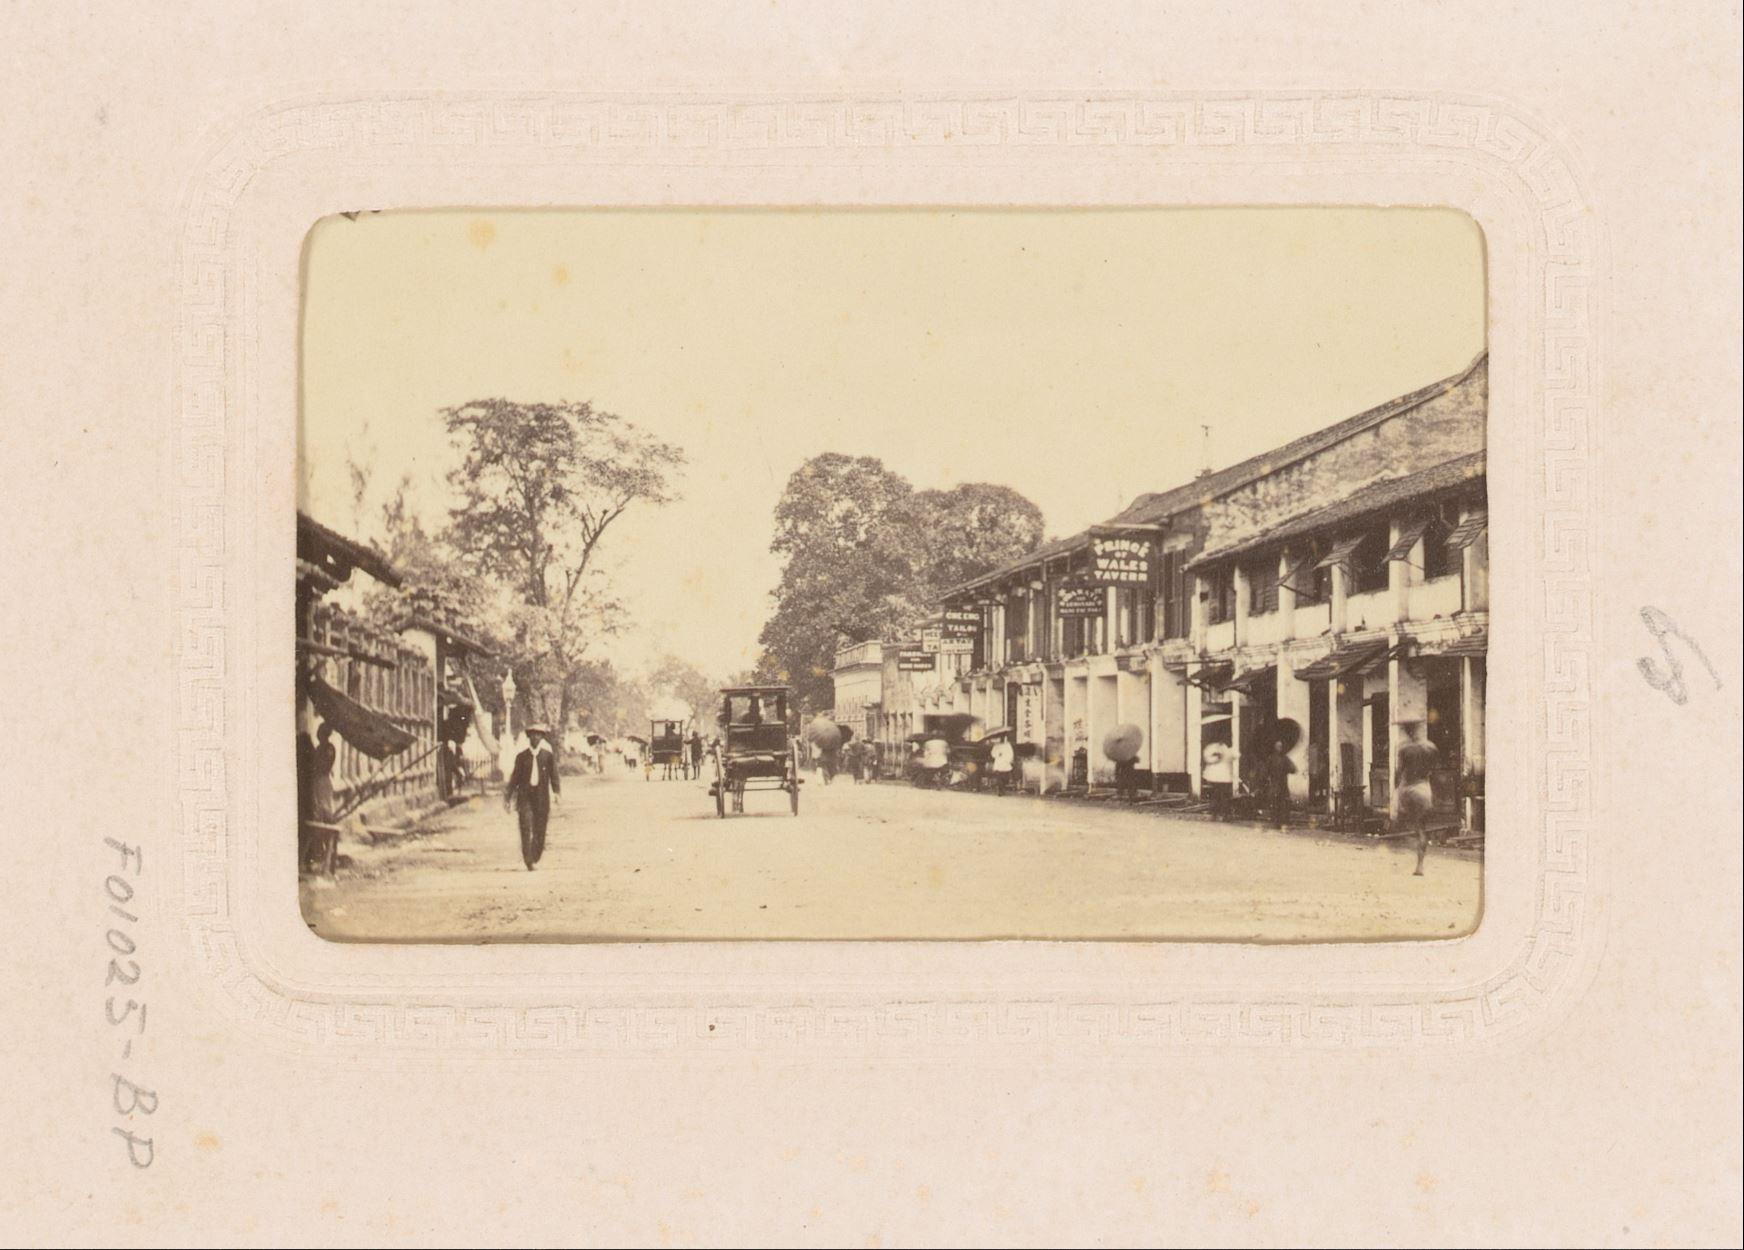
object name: carte de visite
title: Straatgezicht van de North Bridge Road te Singapore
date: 1867-1880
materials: cardboard, photographic support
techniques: albumen print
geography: singapore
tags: street (+ city(-scape) with figures, staffage), singapore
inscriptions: annotation: ‘Singapore’, inscription: ‘G.R. Lambert & Co./ Photographers/ Singapore’, number: ‘68’